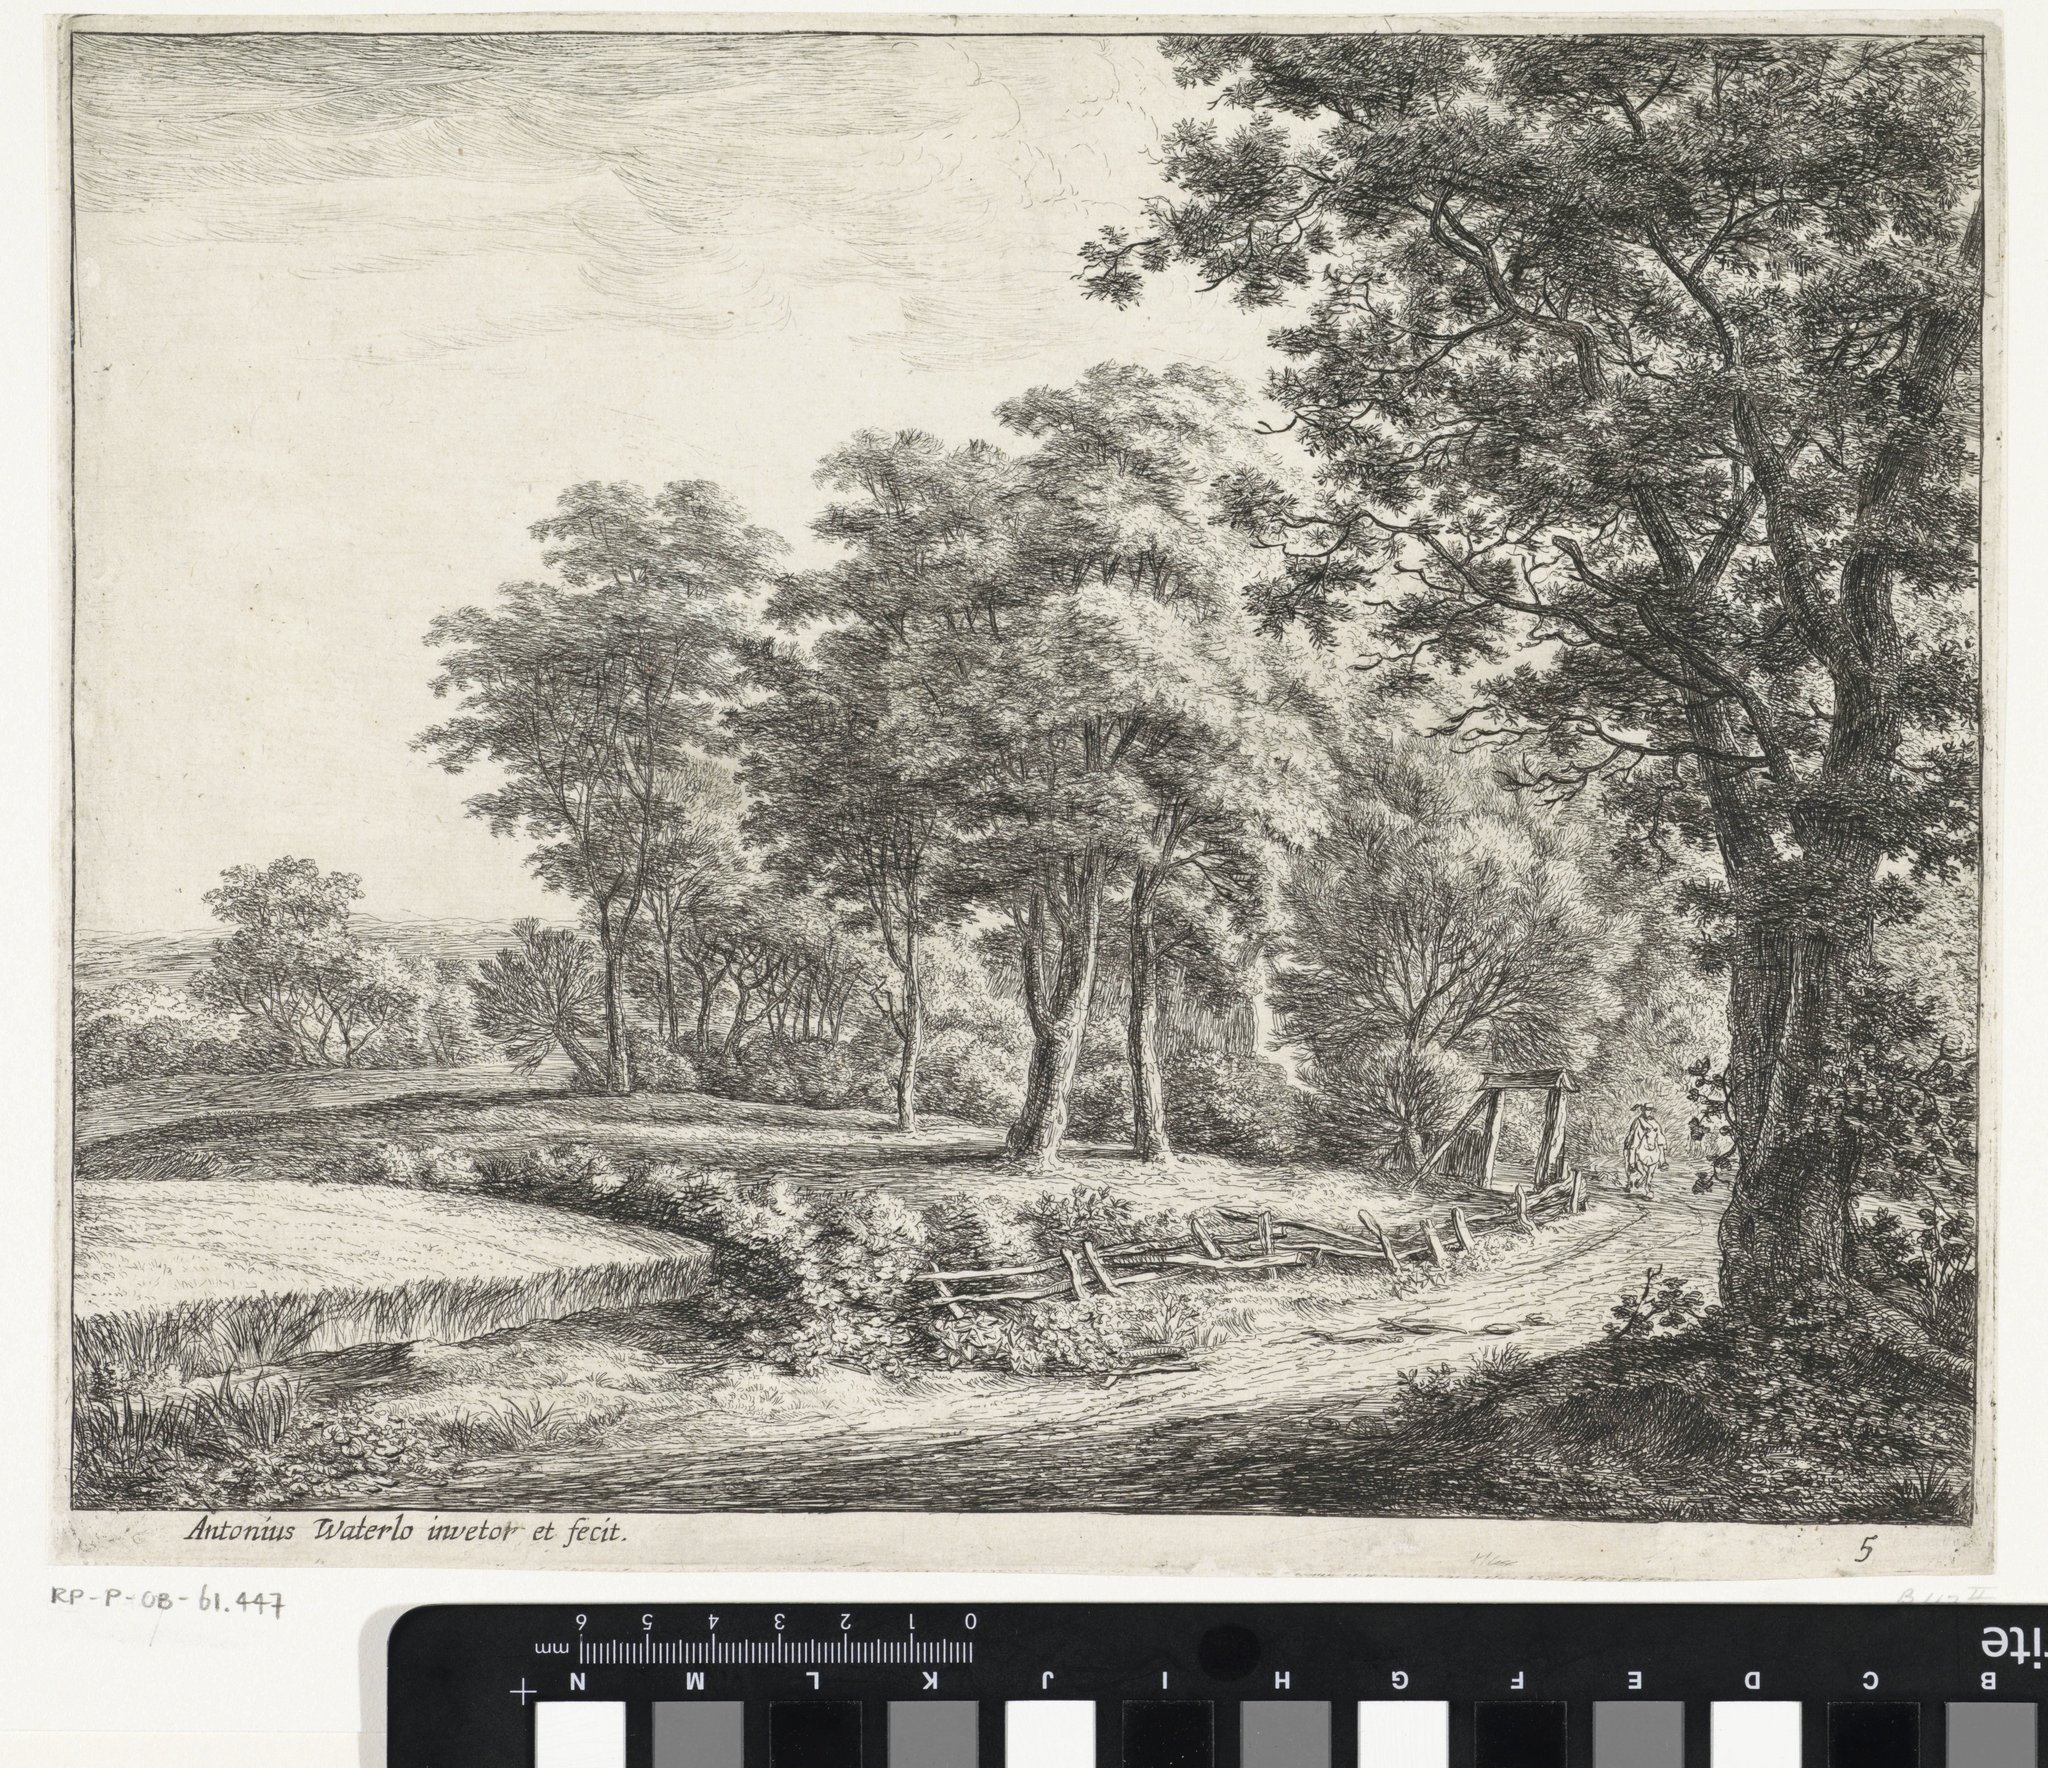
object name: print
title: Ruiter bij een hek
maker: anthonie waterloo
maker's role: draughtsman, painter, print maker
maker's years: 1609-1690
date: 1630-1663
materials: paper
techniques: etching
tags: riding a horse, ass, or mule; rider, horseman, fence, wall, paling, forest path or lane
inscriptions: collector's mark: Lugt 240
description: Een ruiter rijdt op een bospad. Links is een vervallen, houten hek met een houten poort te zien.